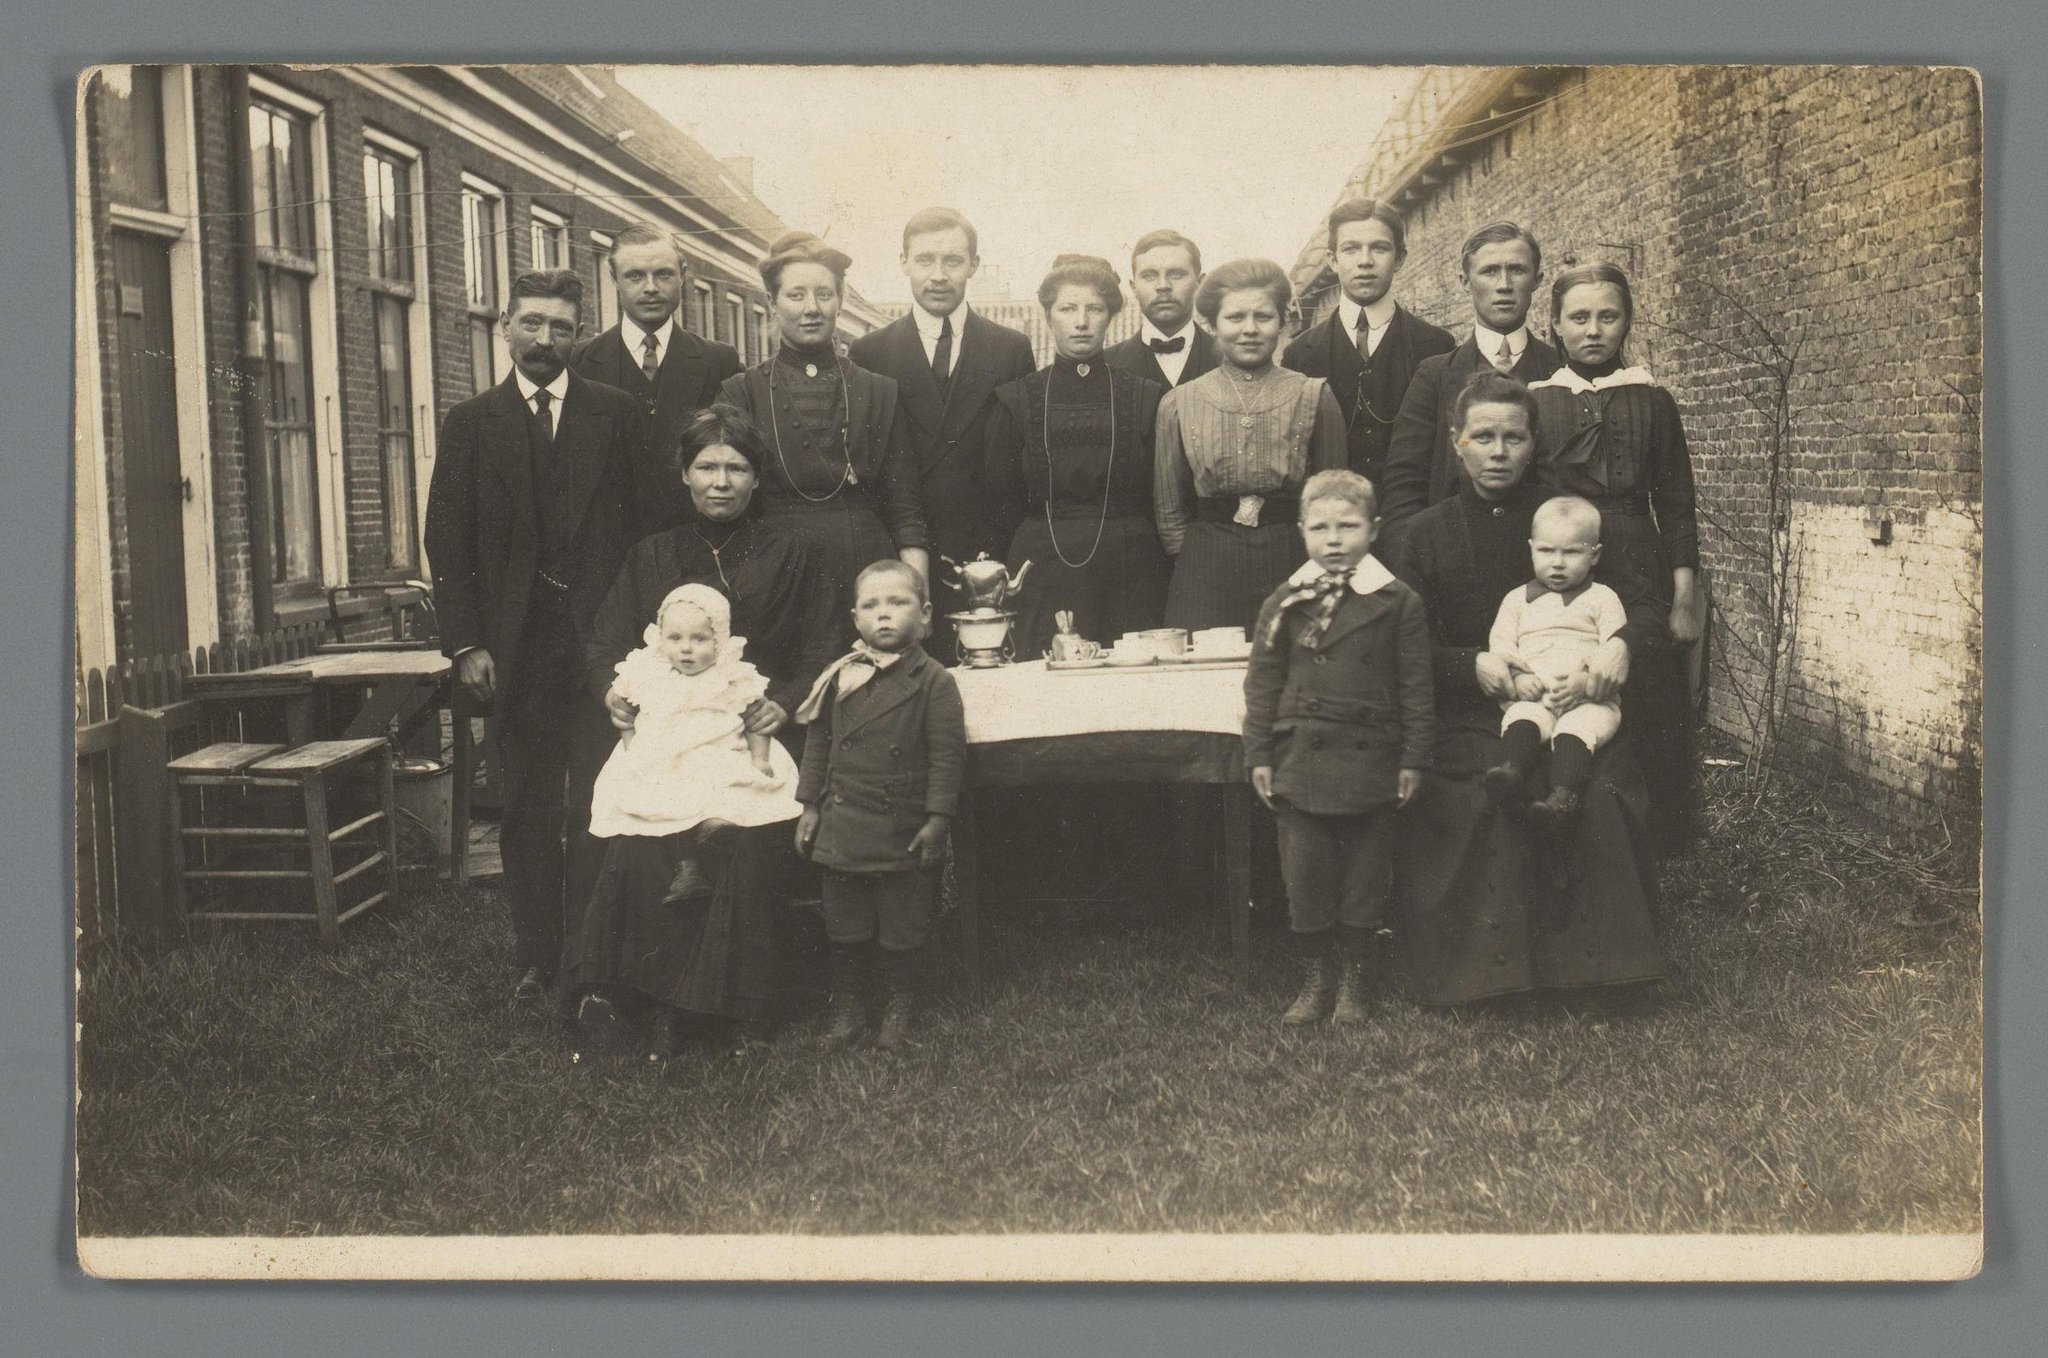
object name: ansichtkaart, prentbriefkaart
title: Groepsportret van de familie Wielenga staand rond een tafel aan de Baljéebuurt 58, Leeuwarden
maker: Anonymous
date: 1905-1920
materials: paper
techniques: gelatin silver print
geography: leeuwarden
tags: family group, especially parents with their child(ren)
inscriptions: inscription: ‘T.J. Wielenga/ Balje buurt 58/ Leeuwarden. Mij H. v. Dijk p/a/ Aan den Heer J. van Dijk/ Vishandel/ Rotstergaast’